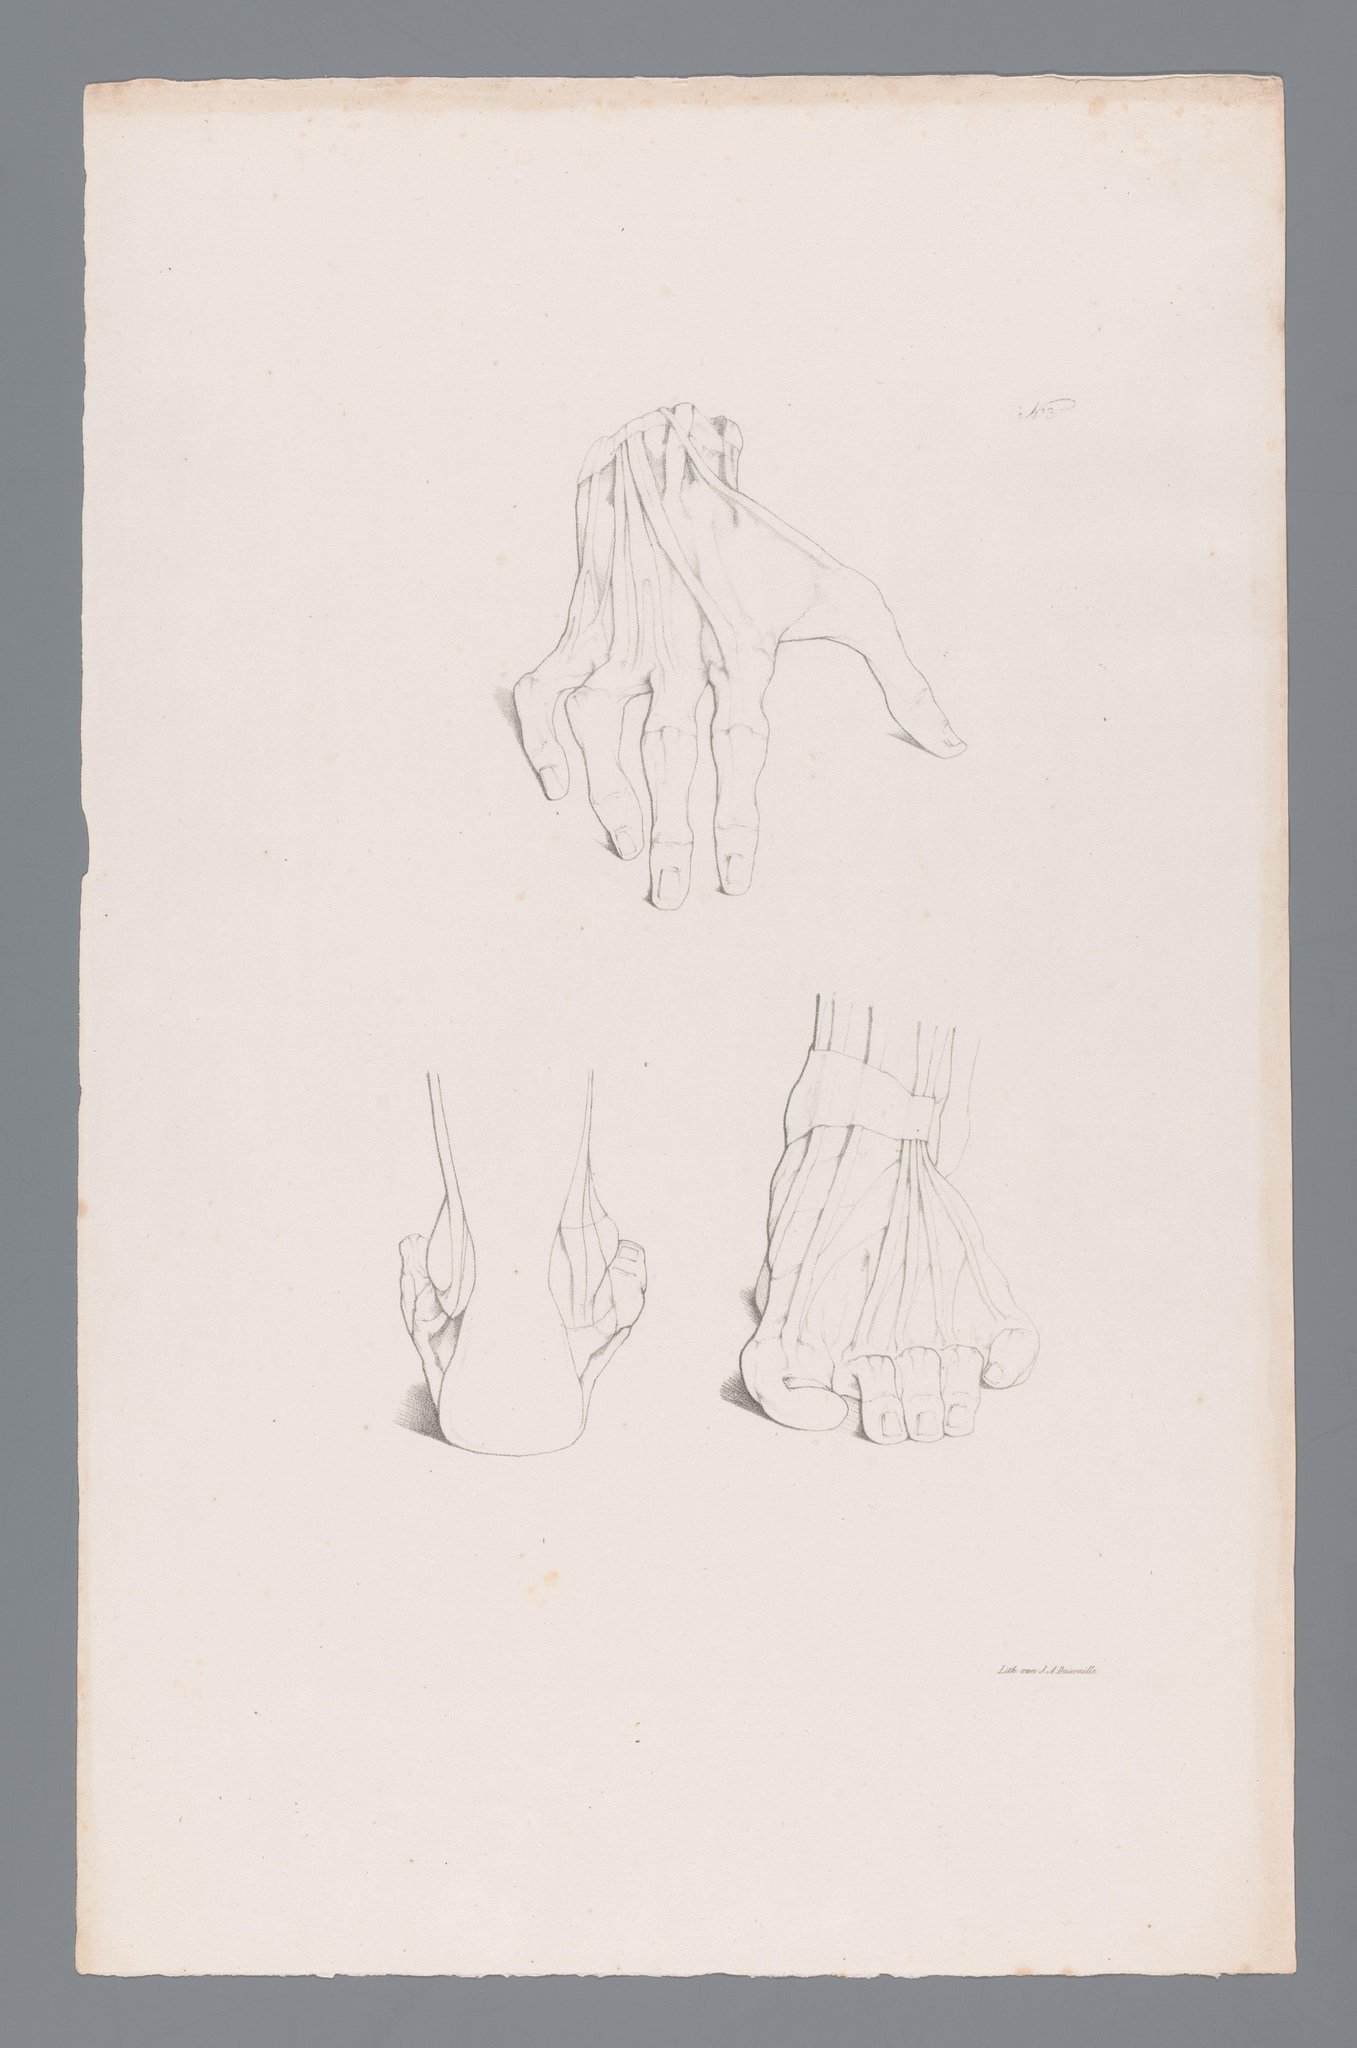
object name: print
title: Anatomie-studien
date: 1828-1830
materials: paper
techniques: lithograph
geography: amsterdam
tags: hand, foot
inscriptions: watermark, collector's mark: Lugt 2228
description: Onderdeel van een omslag met in totaal achttien anatomische voorstellingen.